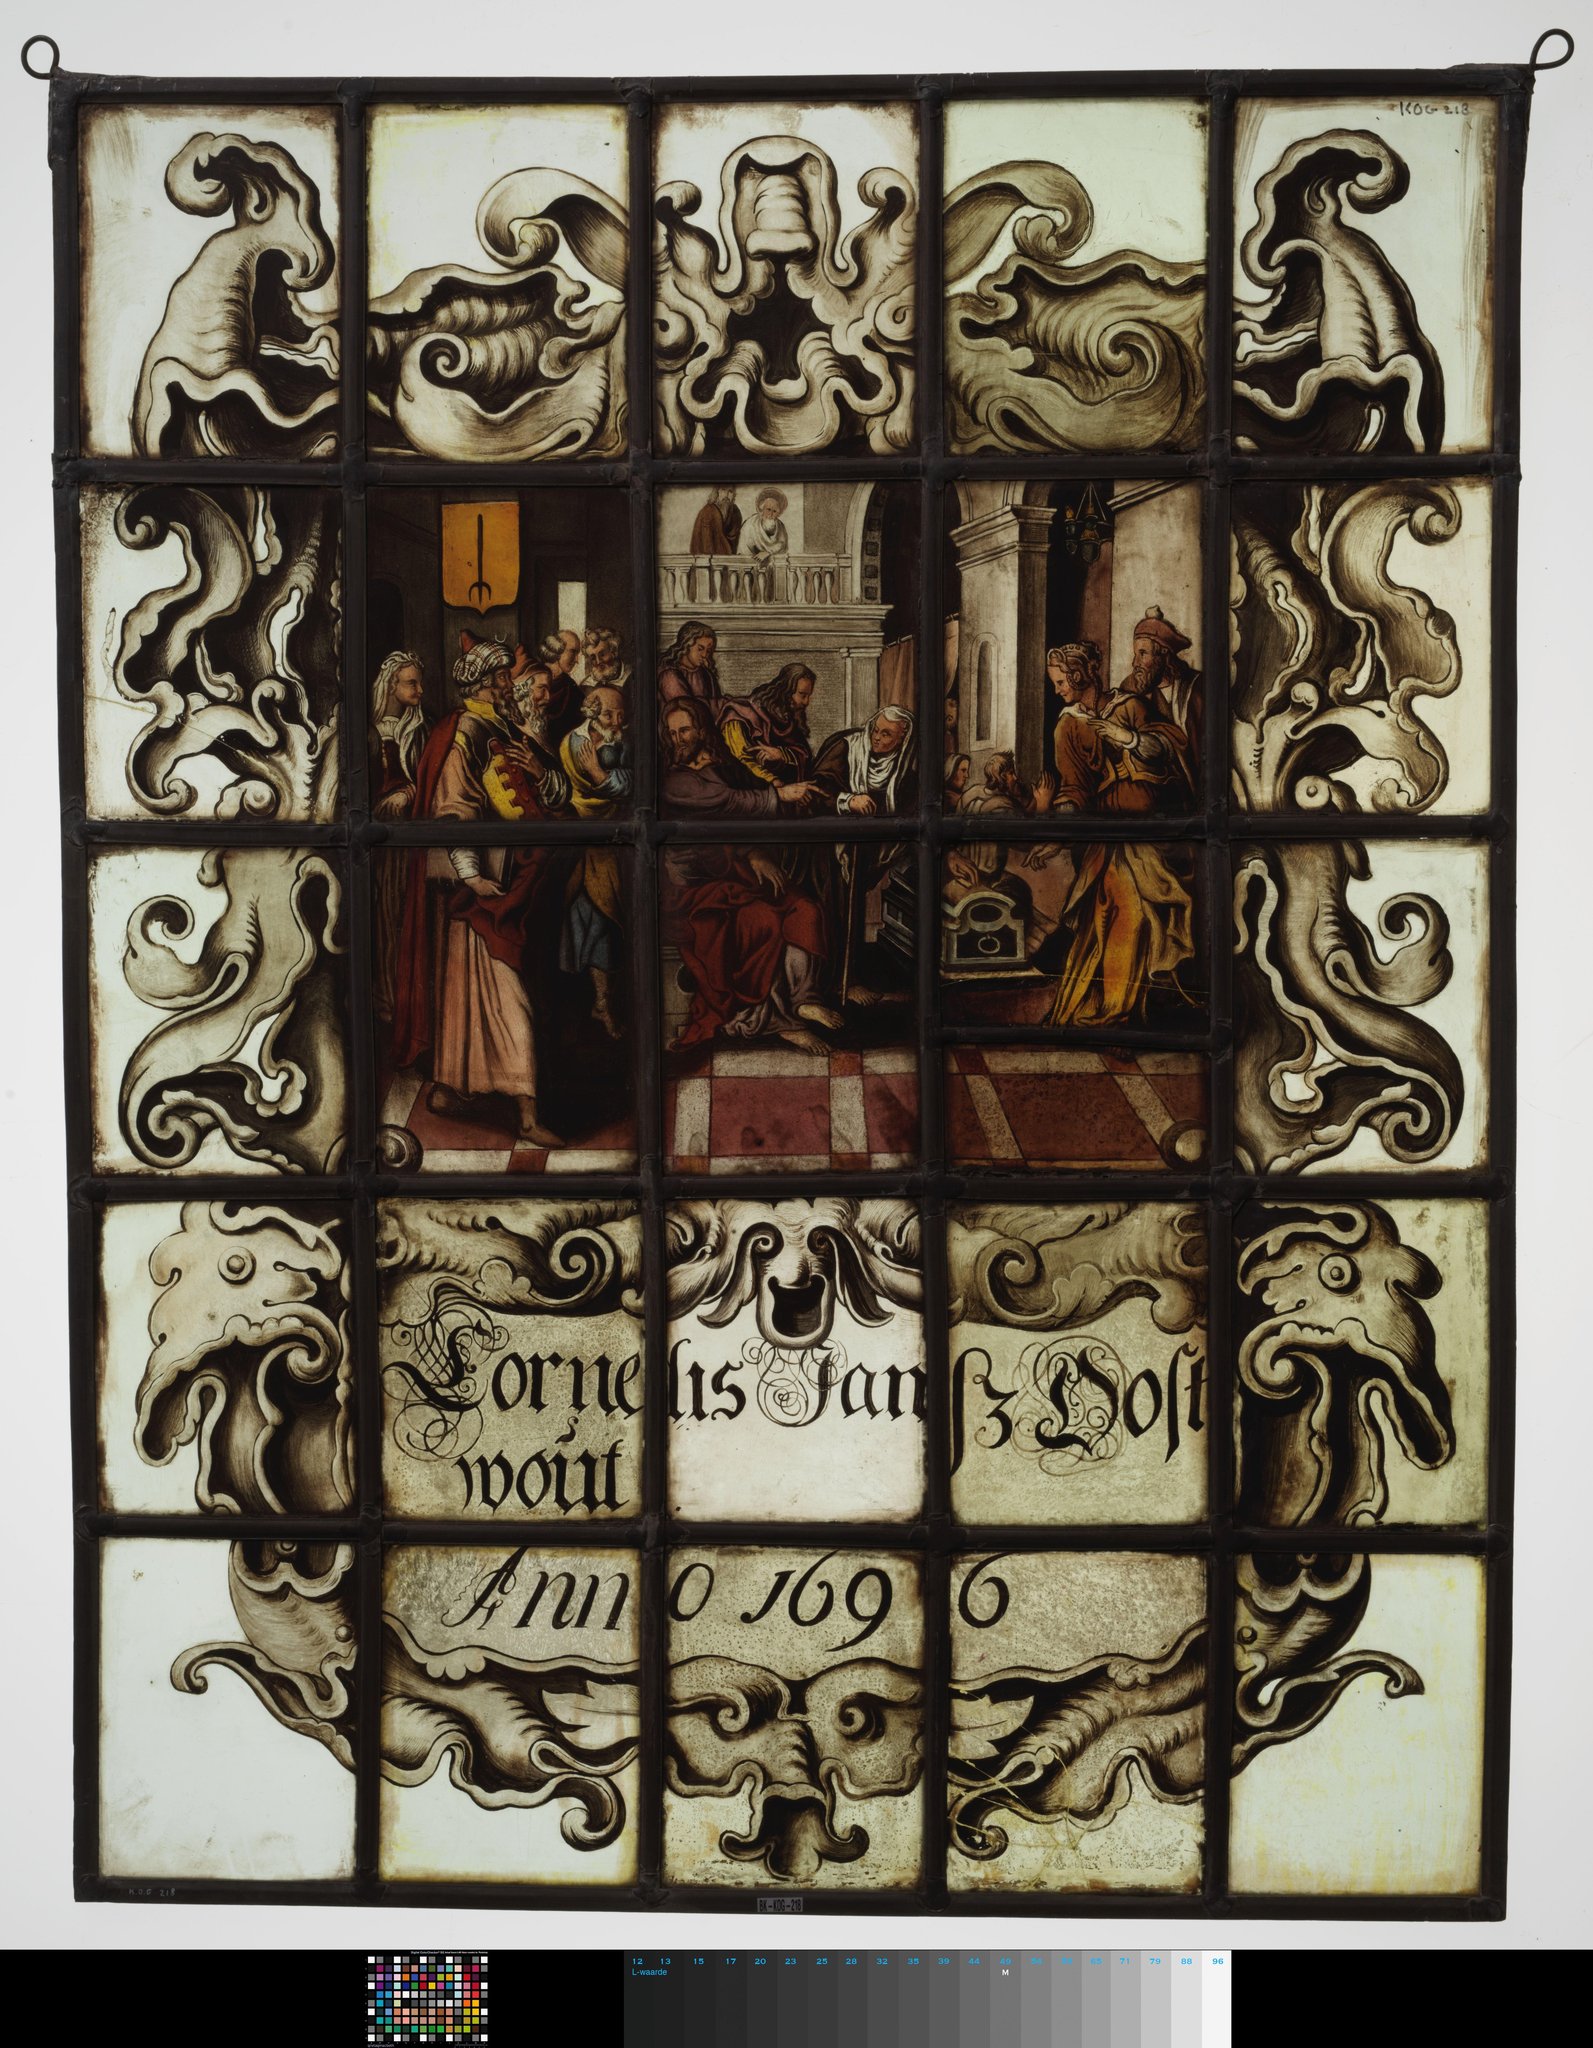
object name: light window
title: Ruit met voorstelling van "Penningske der Weduwe" met onderschrift "Cornelis Jansz. Oostwout Anno 1696" in kwabomlijsting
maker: Anonymous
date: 1696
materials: glass, lead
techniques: leading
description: Ruit met voorstelling van "Penningske der Weduwe" met onderschrift "Cornelis Jansz. Oostwout Anno 1696" in kwabomlijsting. Zie ook inv. nrs. BK-KOG-219, 224 en 225. Afkomstig uit de Ned. Herv. Kerk te Twisk.